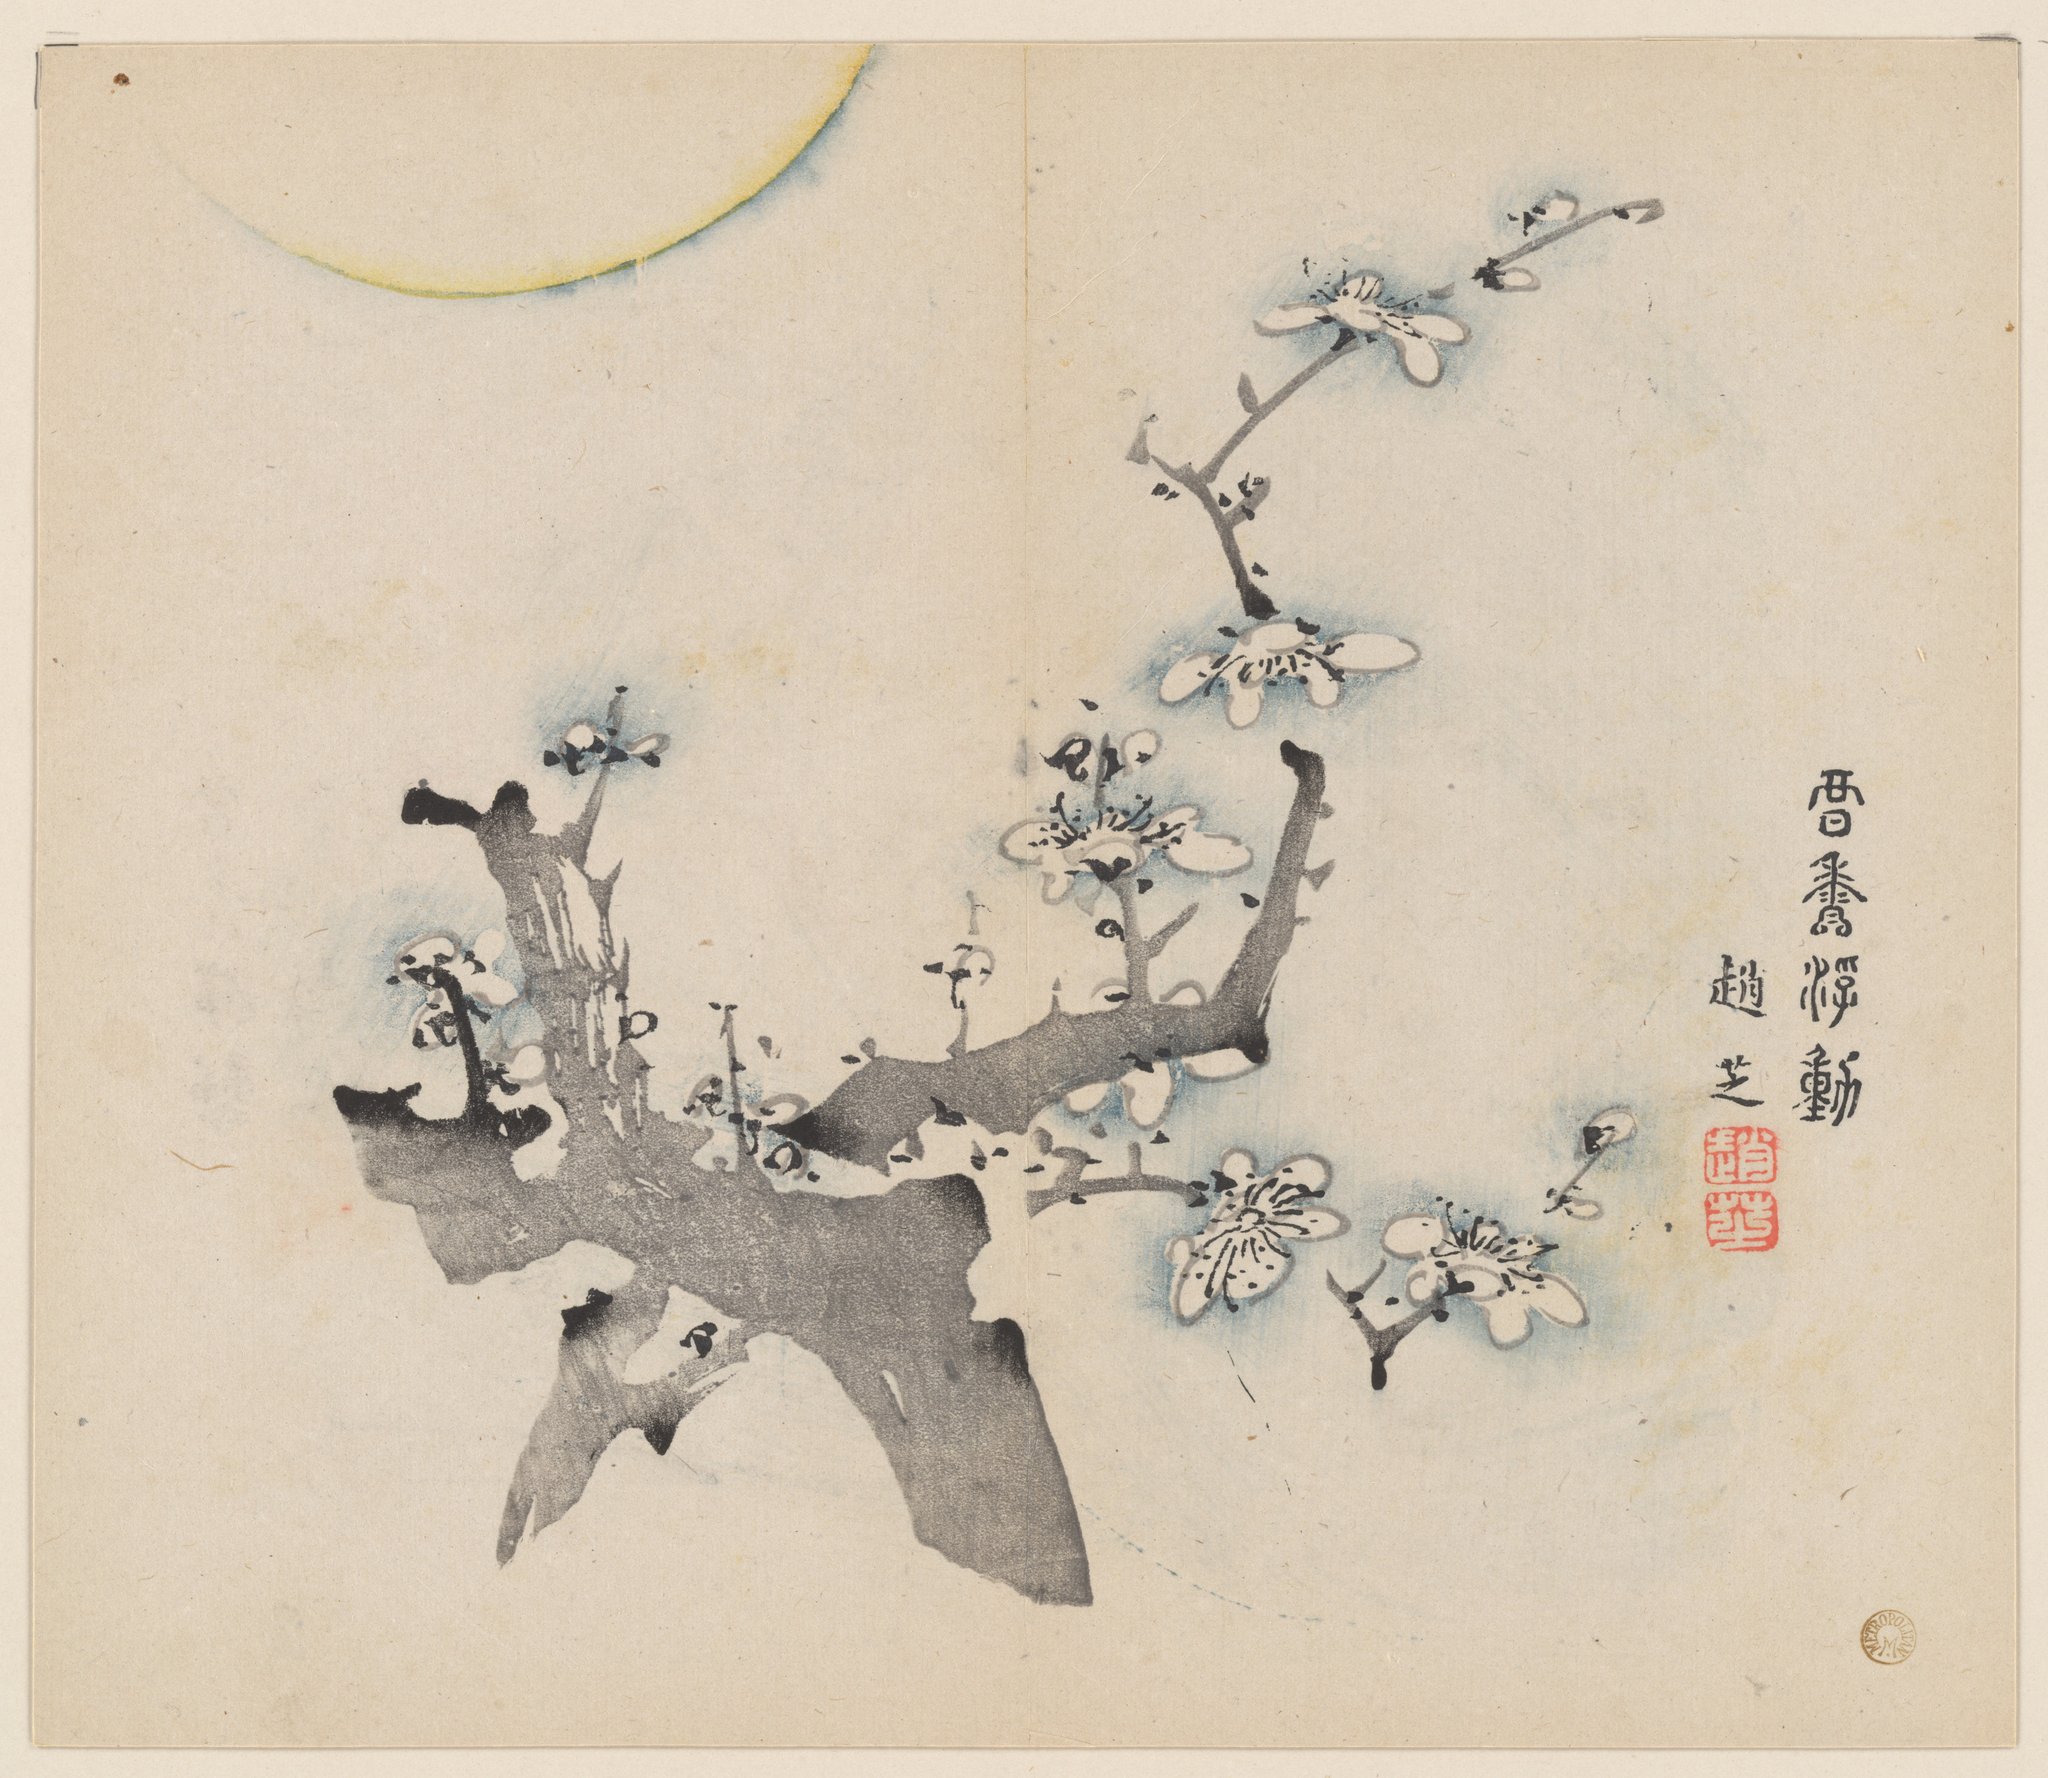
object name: print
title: Page from the Ten Bamboo Studio Manual of Painting and Calligraphy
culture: chinese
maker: hu zhengyan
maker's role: artist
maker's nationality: chinese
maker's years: 1584-1634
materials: ink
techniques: printing